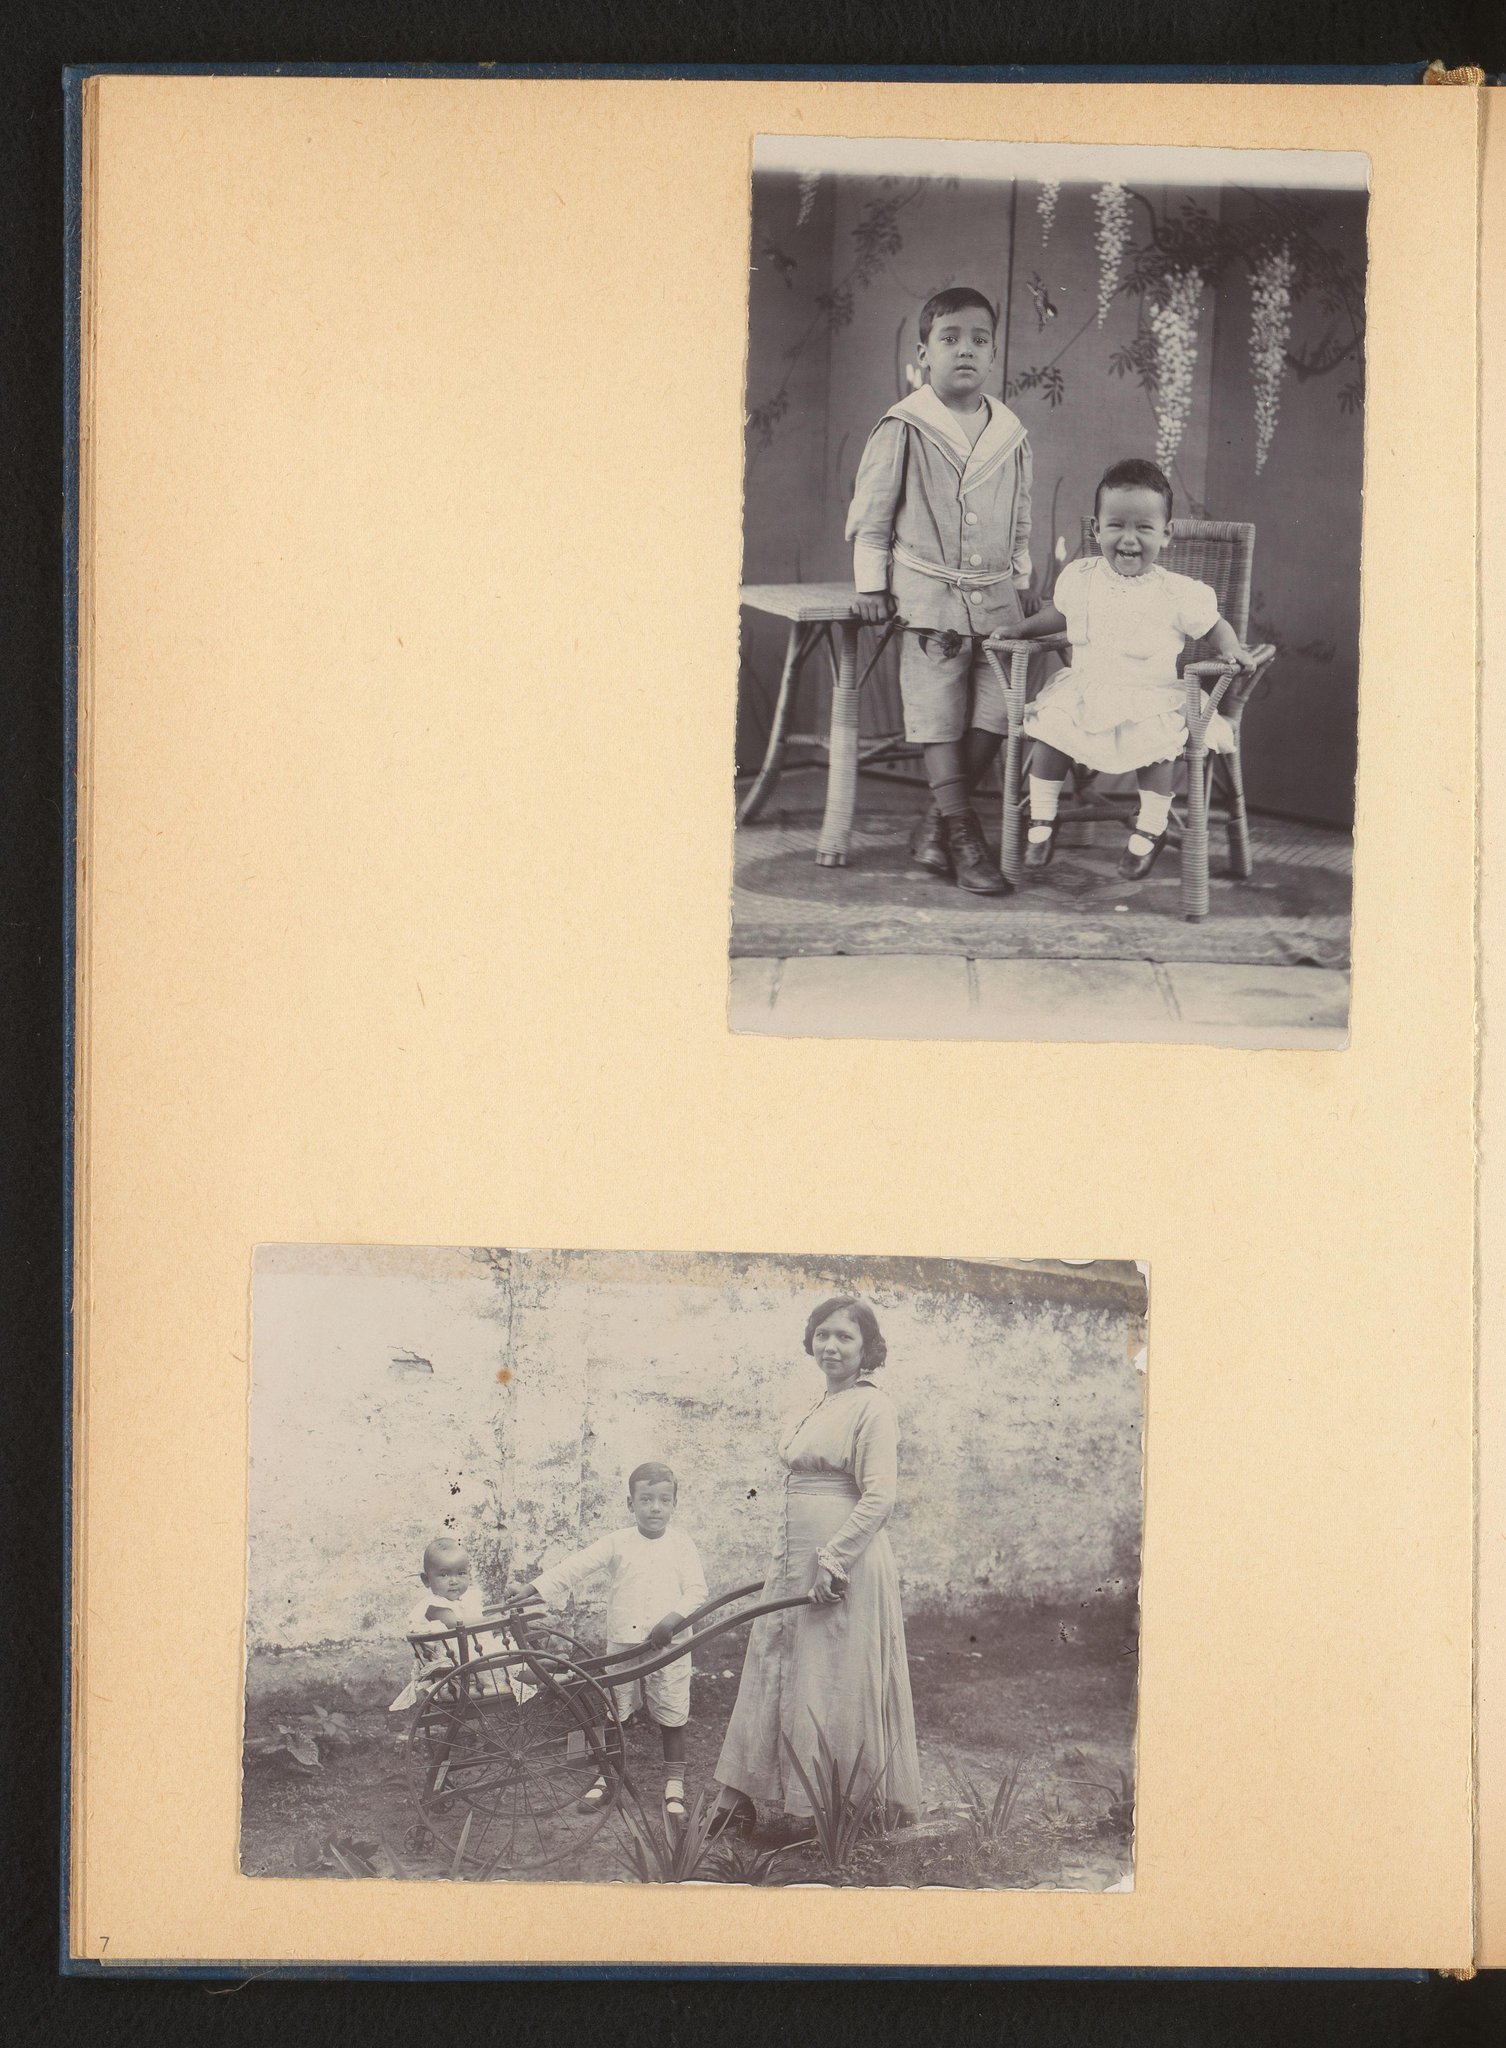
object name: photograph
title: Han en Eef Dumas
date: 1915-1918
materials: cardboard, photographic support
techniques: collodion silver print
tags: paris, beatrice jacqueline eveline dumas, java, baby-carriage, pram, perambulator, historical persons - bb - woman, historical persons, family life at home, toddler - aa - girl, netherlands, dutch east indies, the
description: Blad met twee foto's van Eef Dumas met haar oudere broer Han, poserend in een fotostudio en zittend in een kinderwagen met Han en haar moeder Augustine Pauline Bruins. Onderdeel van het fotoalbum van Beatrice Jacqueline Eveline (Eef) Dumas, ca. 1880-1952.